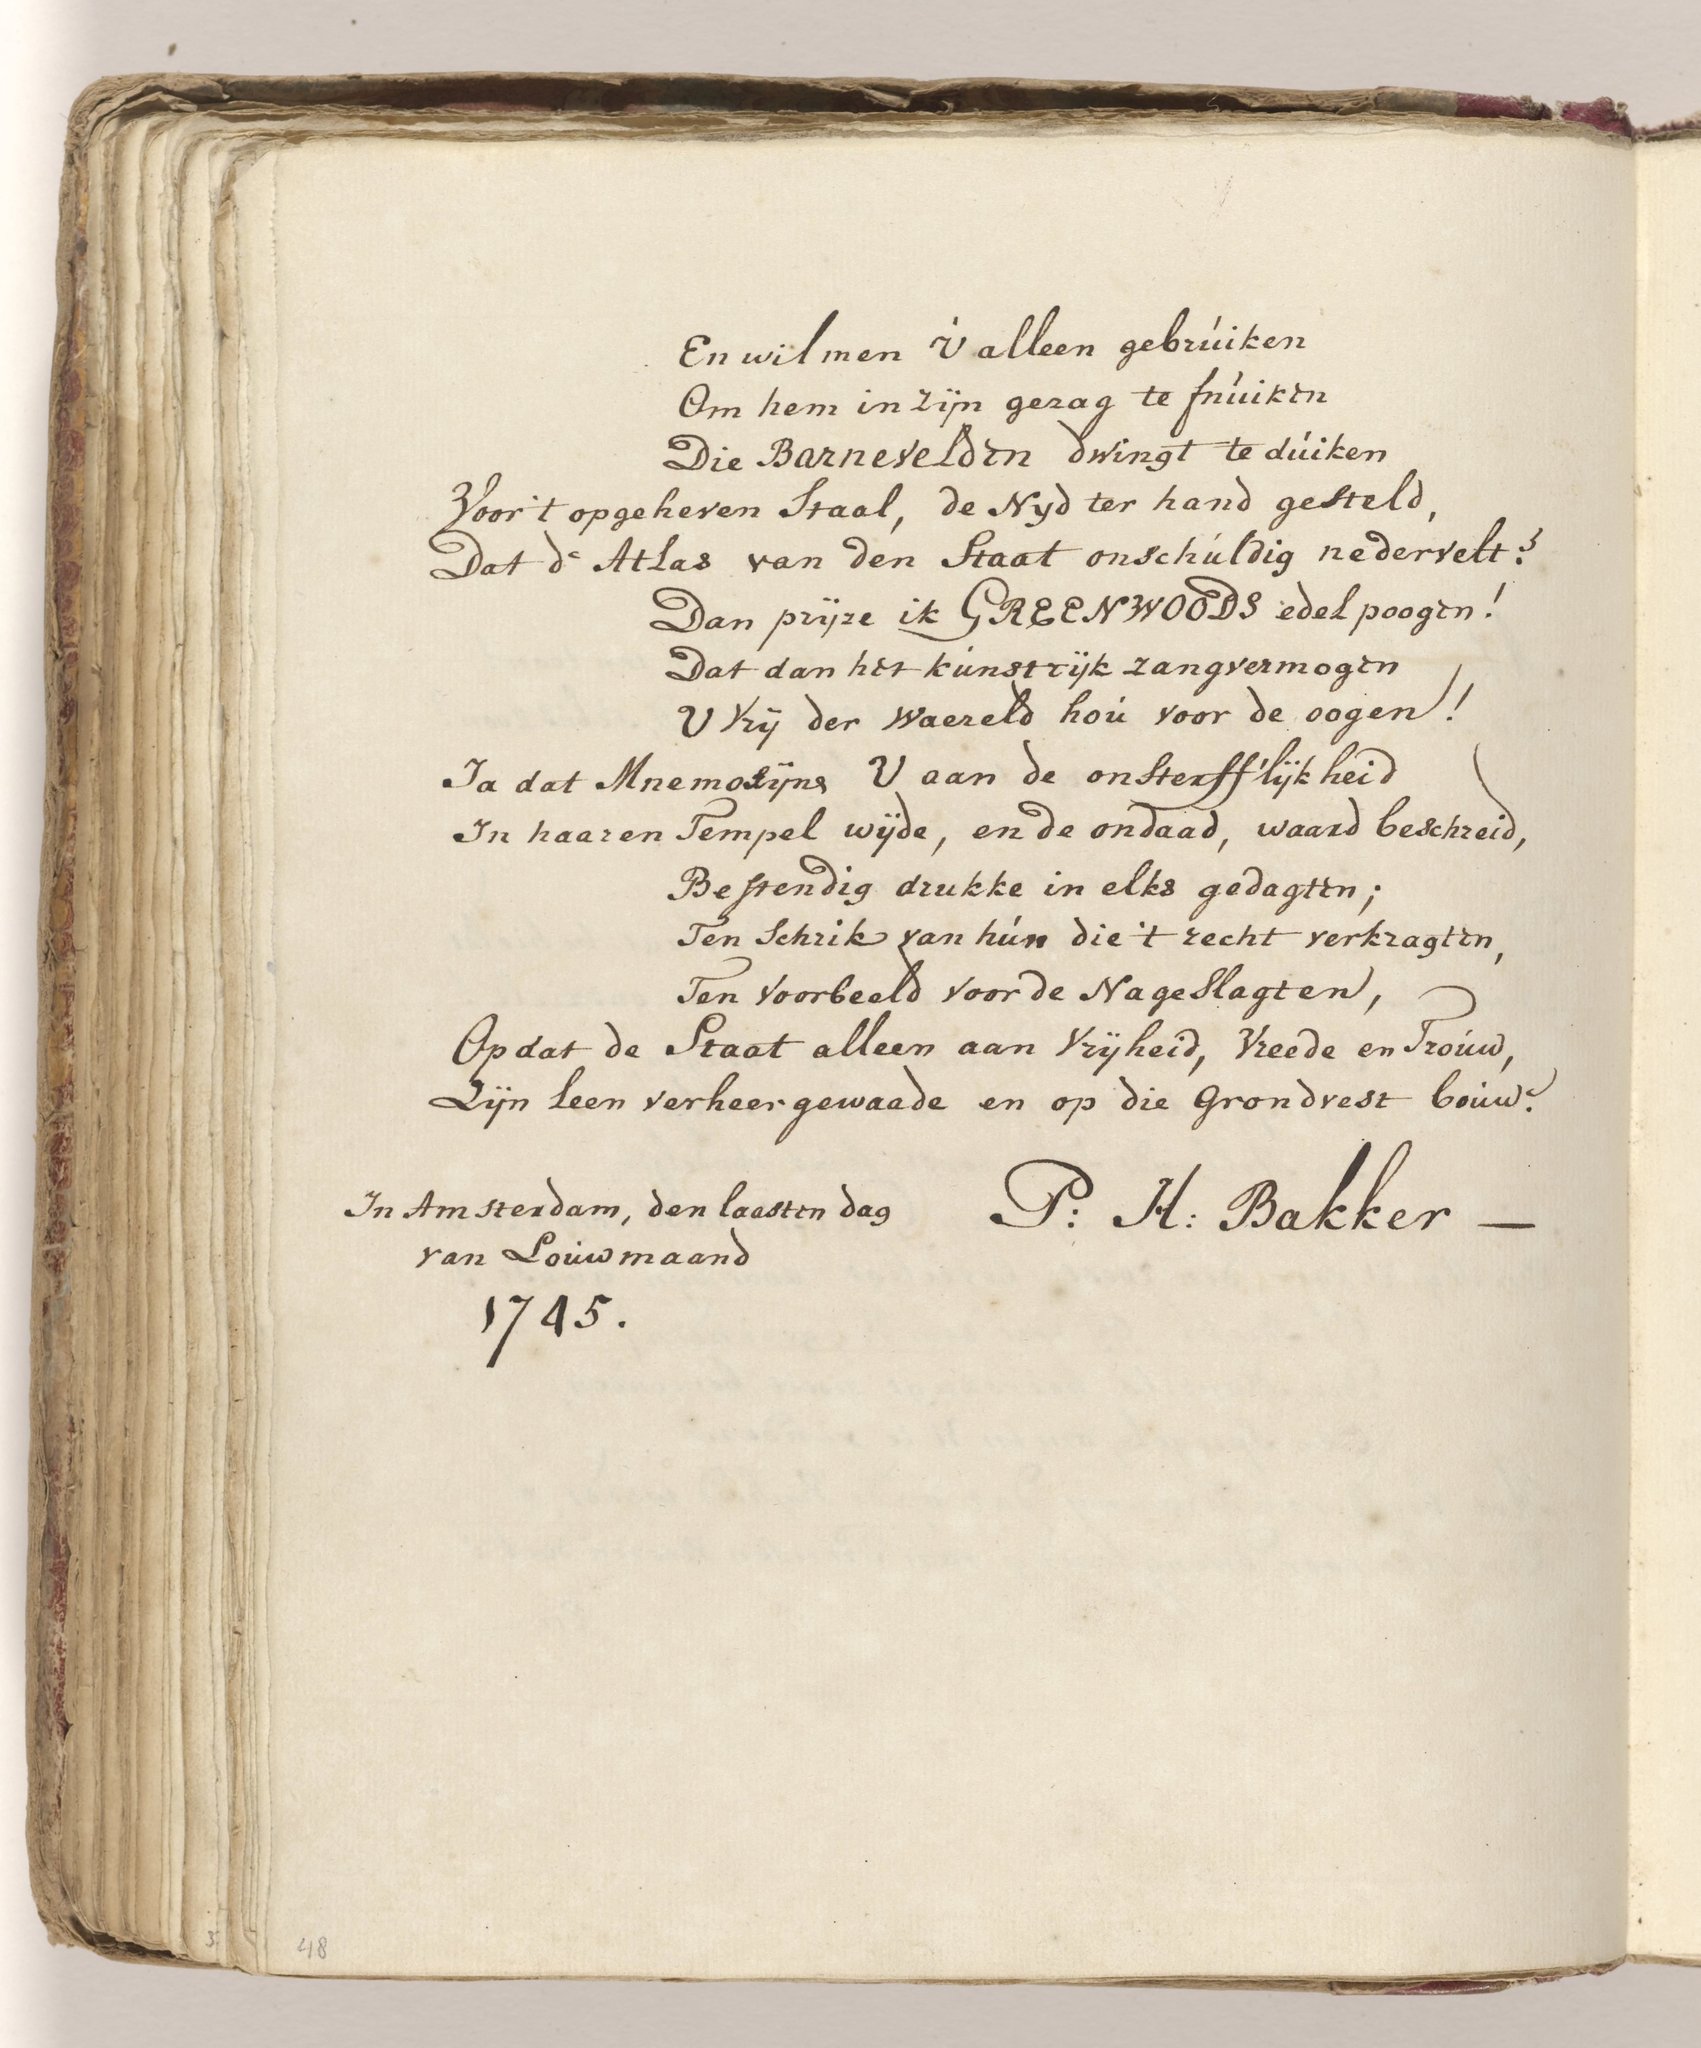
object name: manuscript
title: Gedicht op het zwaard waarmee Johan van Oldenbarnevelt in 1619 zou zijn onthoofd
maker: pieter huizinga bakker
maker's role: dichter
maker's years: 1713-1801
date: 1745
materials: ink, paper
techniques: writing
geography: amsterdam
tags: the hague, johan van oldenbarnevelt, frans greenwood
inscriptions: date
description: Vers van Pieter Huizinga Bakker (tweede deel). Onderdeel van het boek met gedichten uit de jaren 1743-1745 op het zwaard waarmee Johan van Oldenbarnevelt in 1619 zou zijn onthoofd. Het zwaard was eigendom van Frans Greenwood.